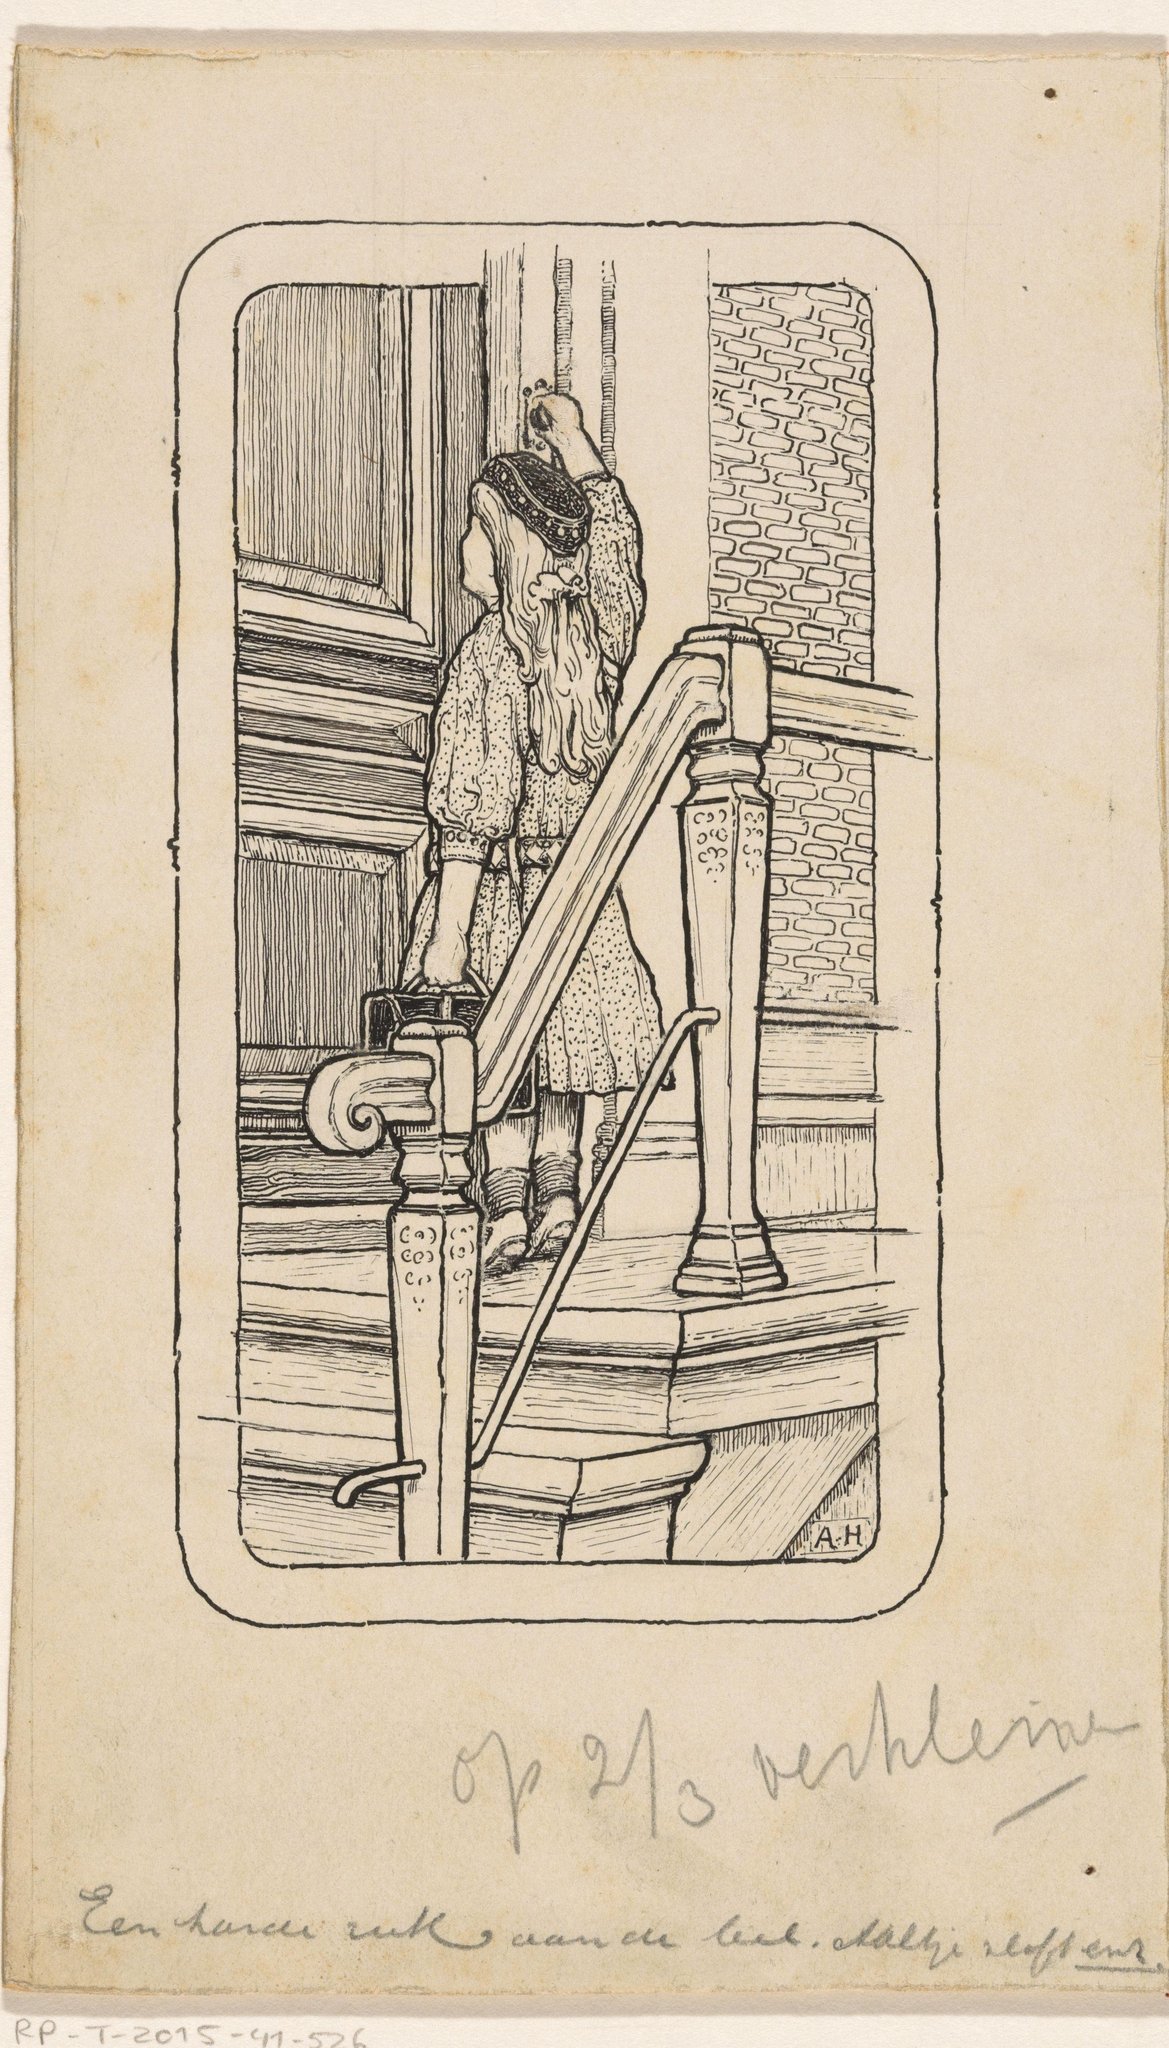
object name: boekillustratie ontwerp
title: Trees belt aan bij een voordeur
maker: albert hemelman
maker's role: draughtsman, print maker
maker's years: 1883-1951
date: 1893-1951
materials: cardboard, ink, pencil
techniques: pen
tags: door-knocker, doorbell, girl (child between toddler and youth), front steps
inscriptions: signature: ‘A.H.’, annotation: ‘Een harde ruk aan de bel. [...]je sloft enz.’, collector's mark: Lugt 2228, :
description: Trees staat op haar tenen op een trap voor een voordeur en belt aan. In haar hand heeft ze een tas.